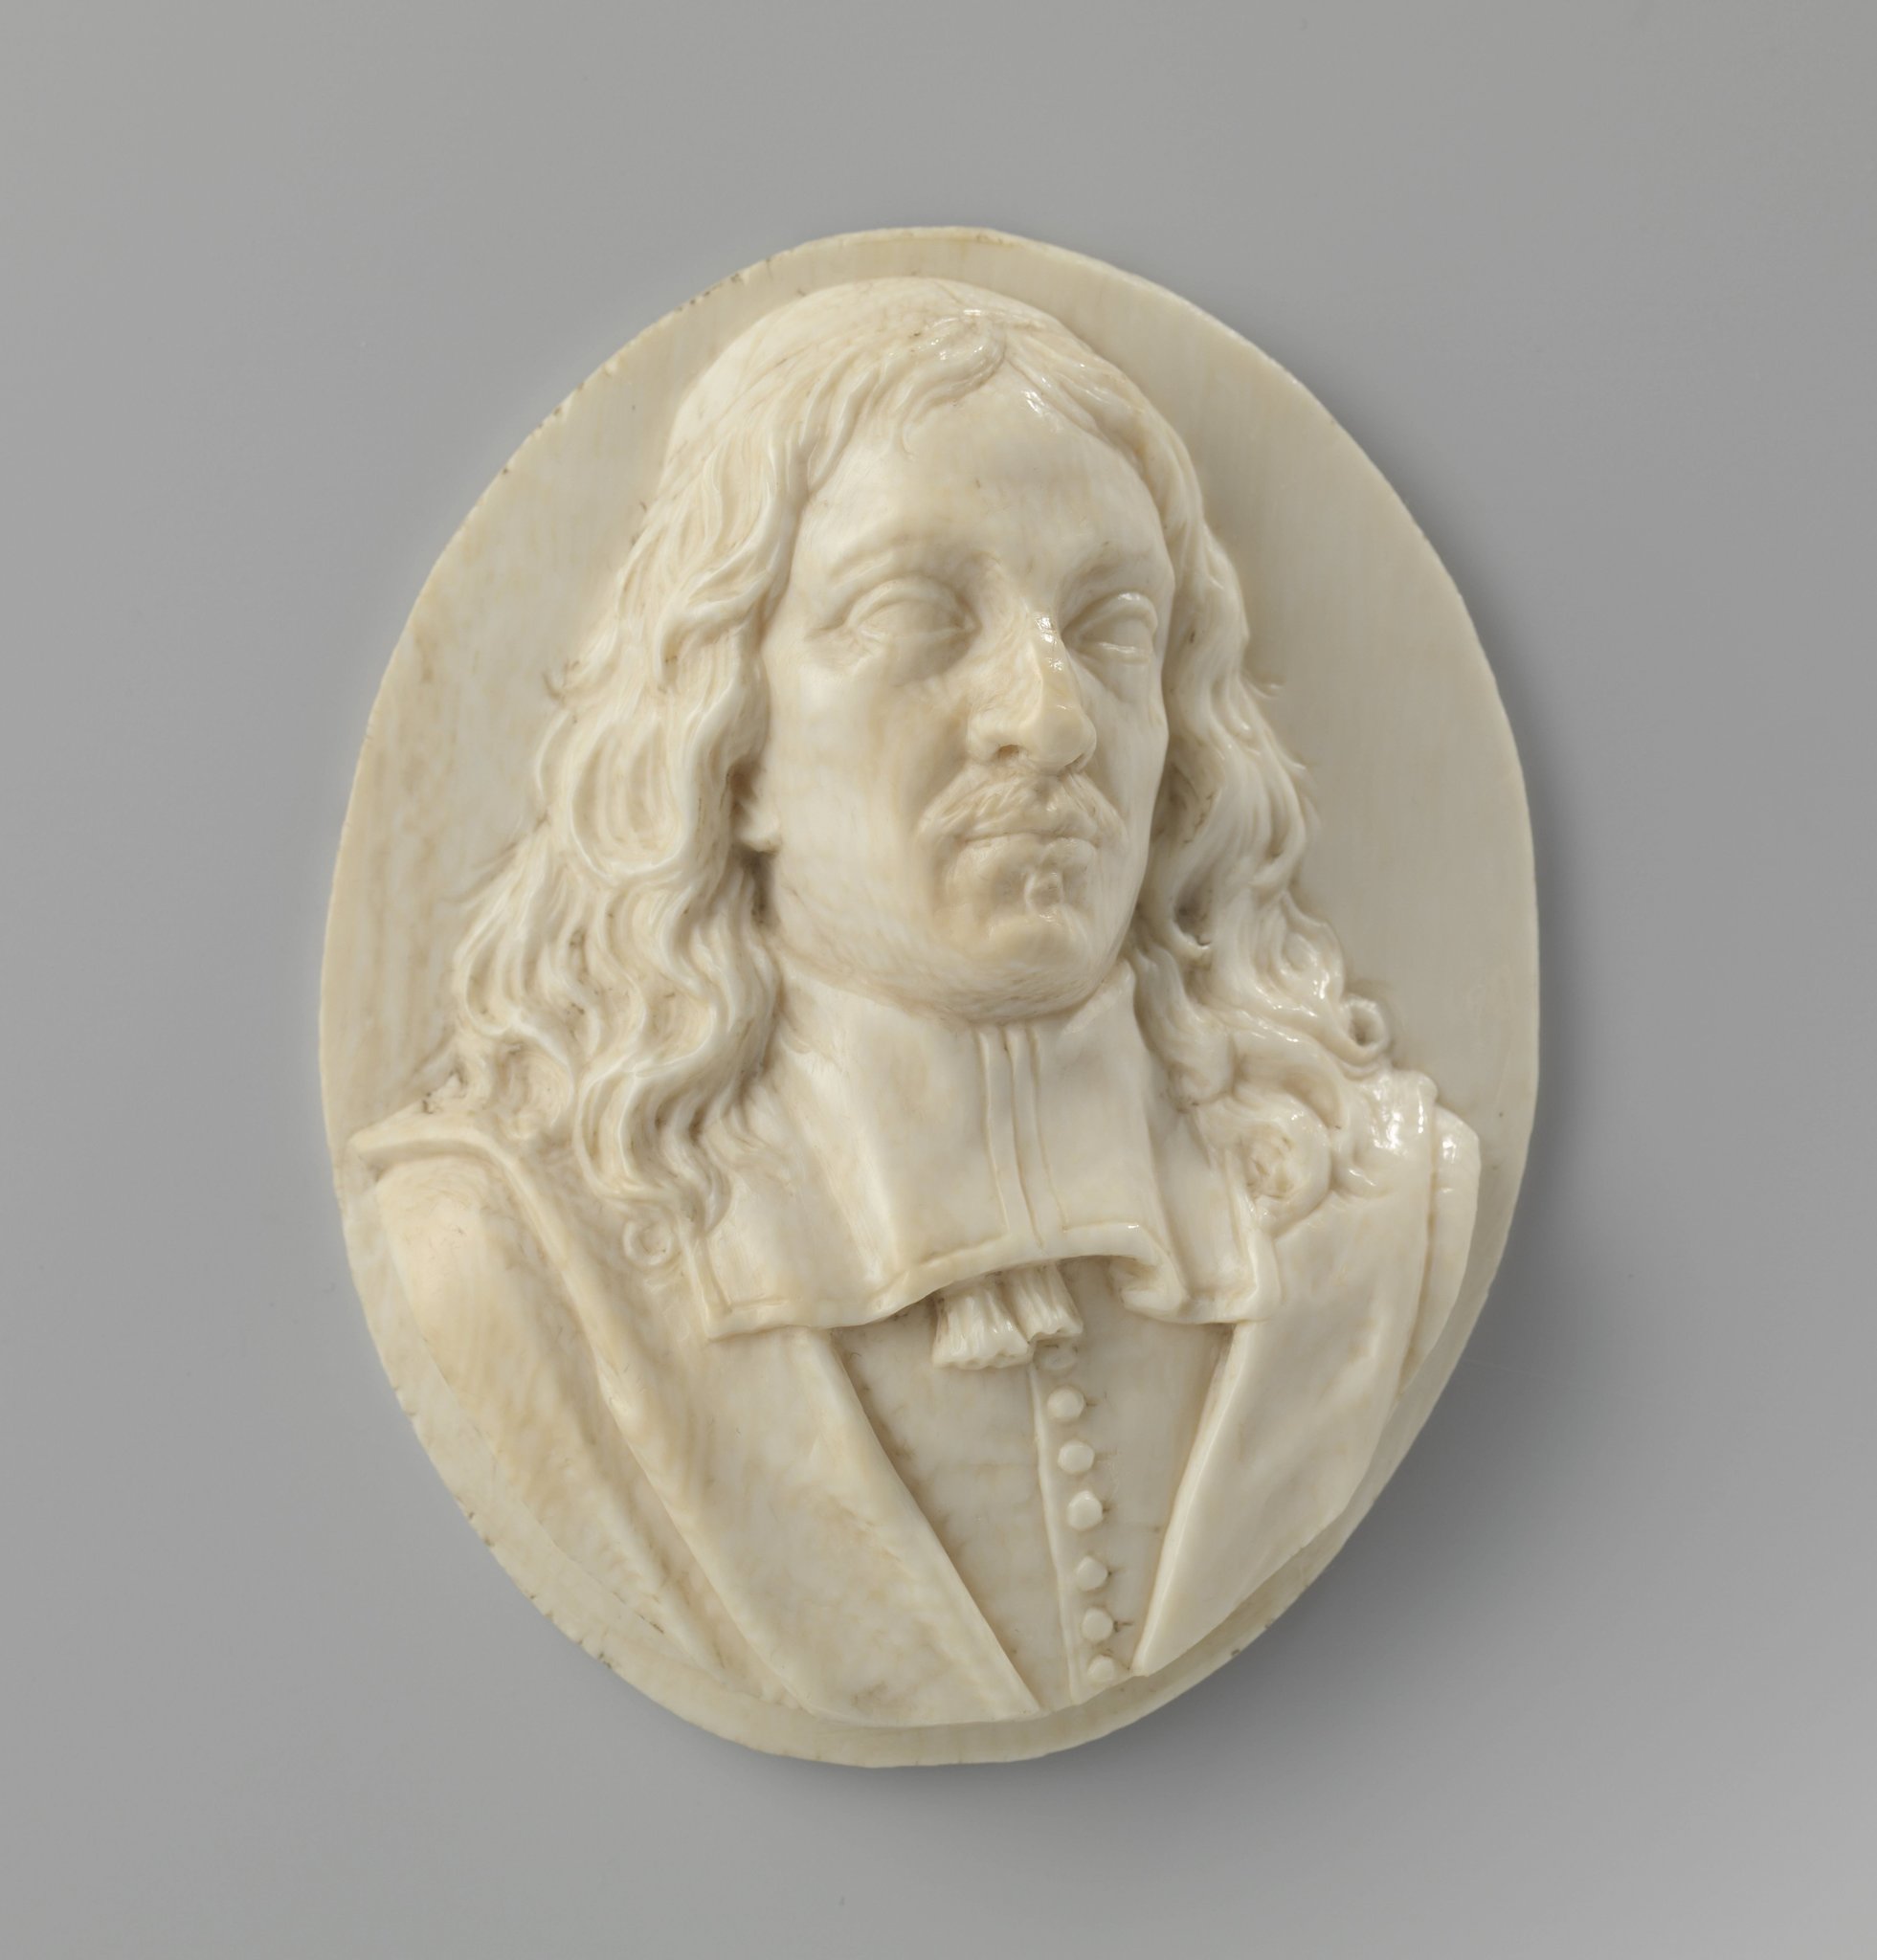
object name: relief sculpture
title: Portrait Medallion of Johan de Witt (1625-1672)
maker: Anonymous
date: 1735-1750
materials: ivory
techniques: cutting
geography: netherlands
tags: the hague, politician, johan de witt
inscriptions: inscription, on the reverse, in ink: ‘Jan de Witt / Vente J. Moyet Amsterdam 1859 / J. Meulman Amsterdam 1869’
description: Portrait medallions of the De Witt brothers. Ivory, Northern Netherlands, 17th century.